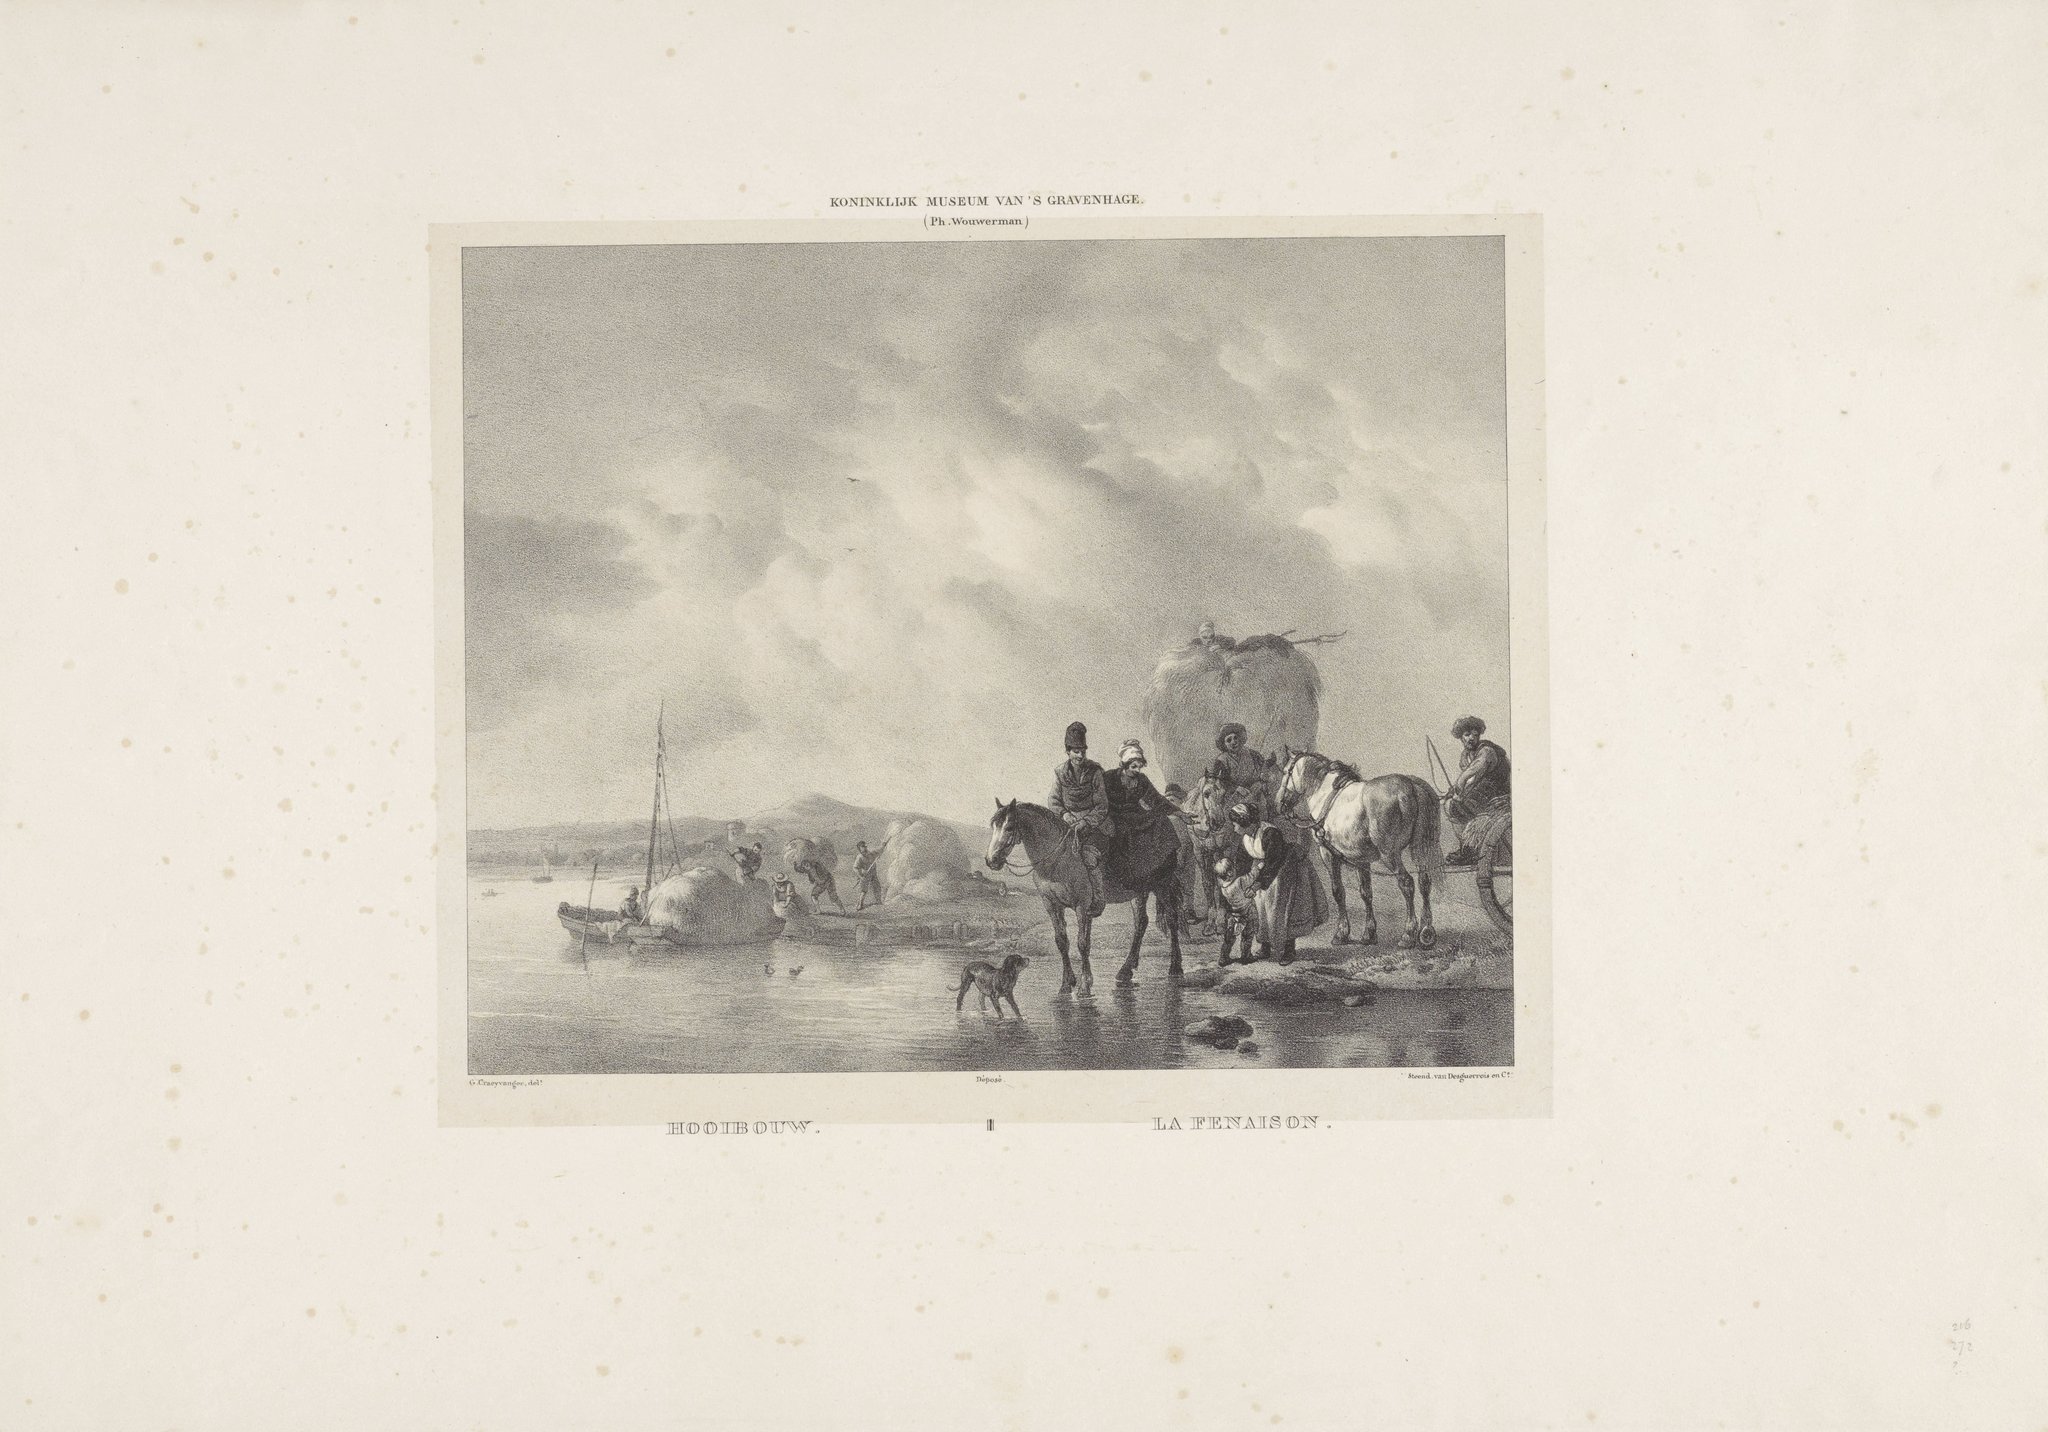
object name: book illustration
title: Hooibouw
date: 1833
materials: paper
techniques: lithograph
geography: amsterdam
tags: crossing a river, harvest, agricultural products and by-products: hay, hay-wagon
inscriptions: collector's mark: Lugt 2228, : ‘Déposé’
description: Een groep, bestaande uit mannen, vrouwen en een kind, is bezig gemaaid gras middels paard en wagen en een boot de rivier over te transporteren. De prent werd gemaakt naar een schilderij van Philips Wouwermans in het Mauritshuis in Den Haag.